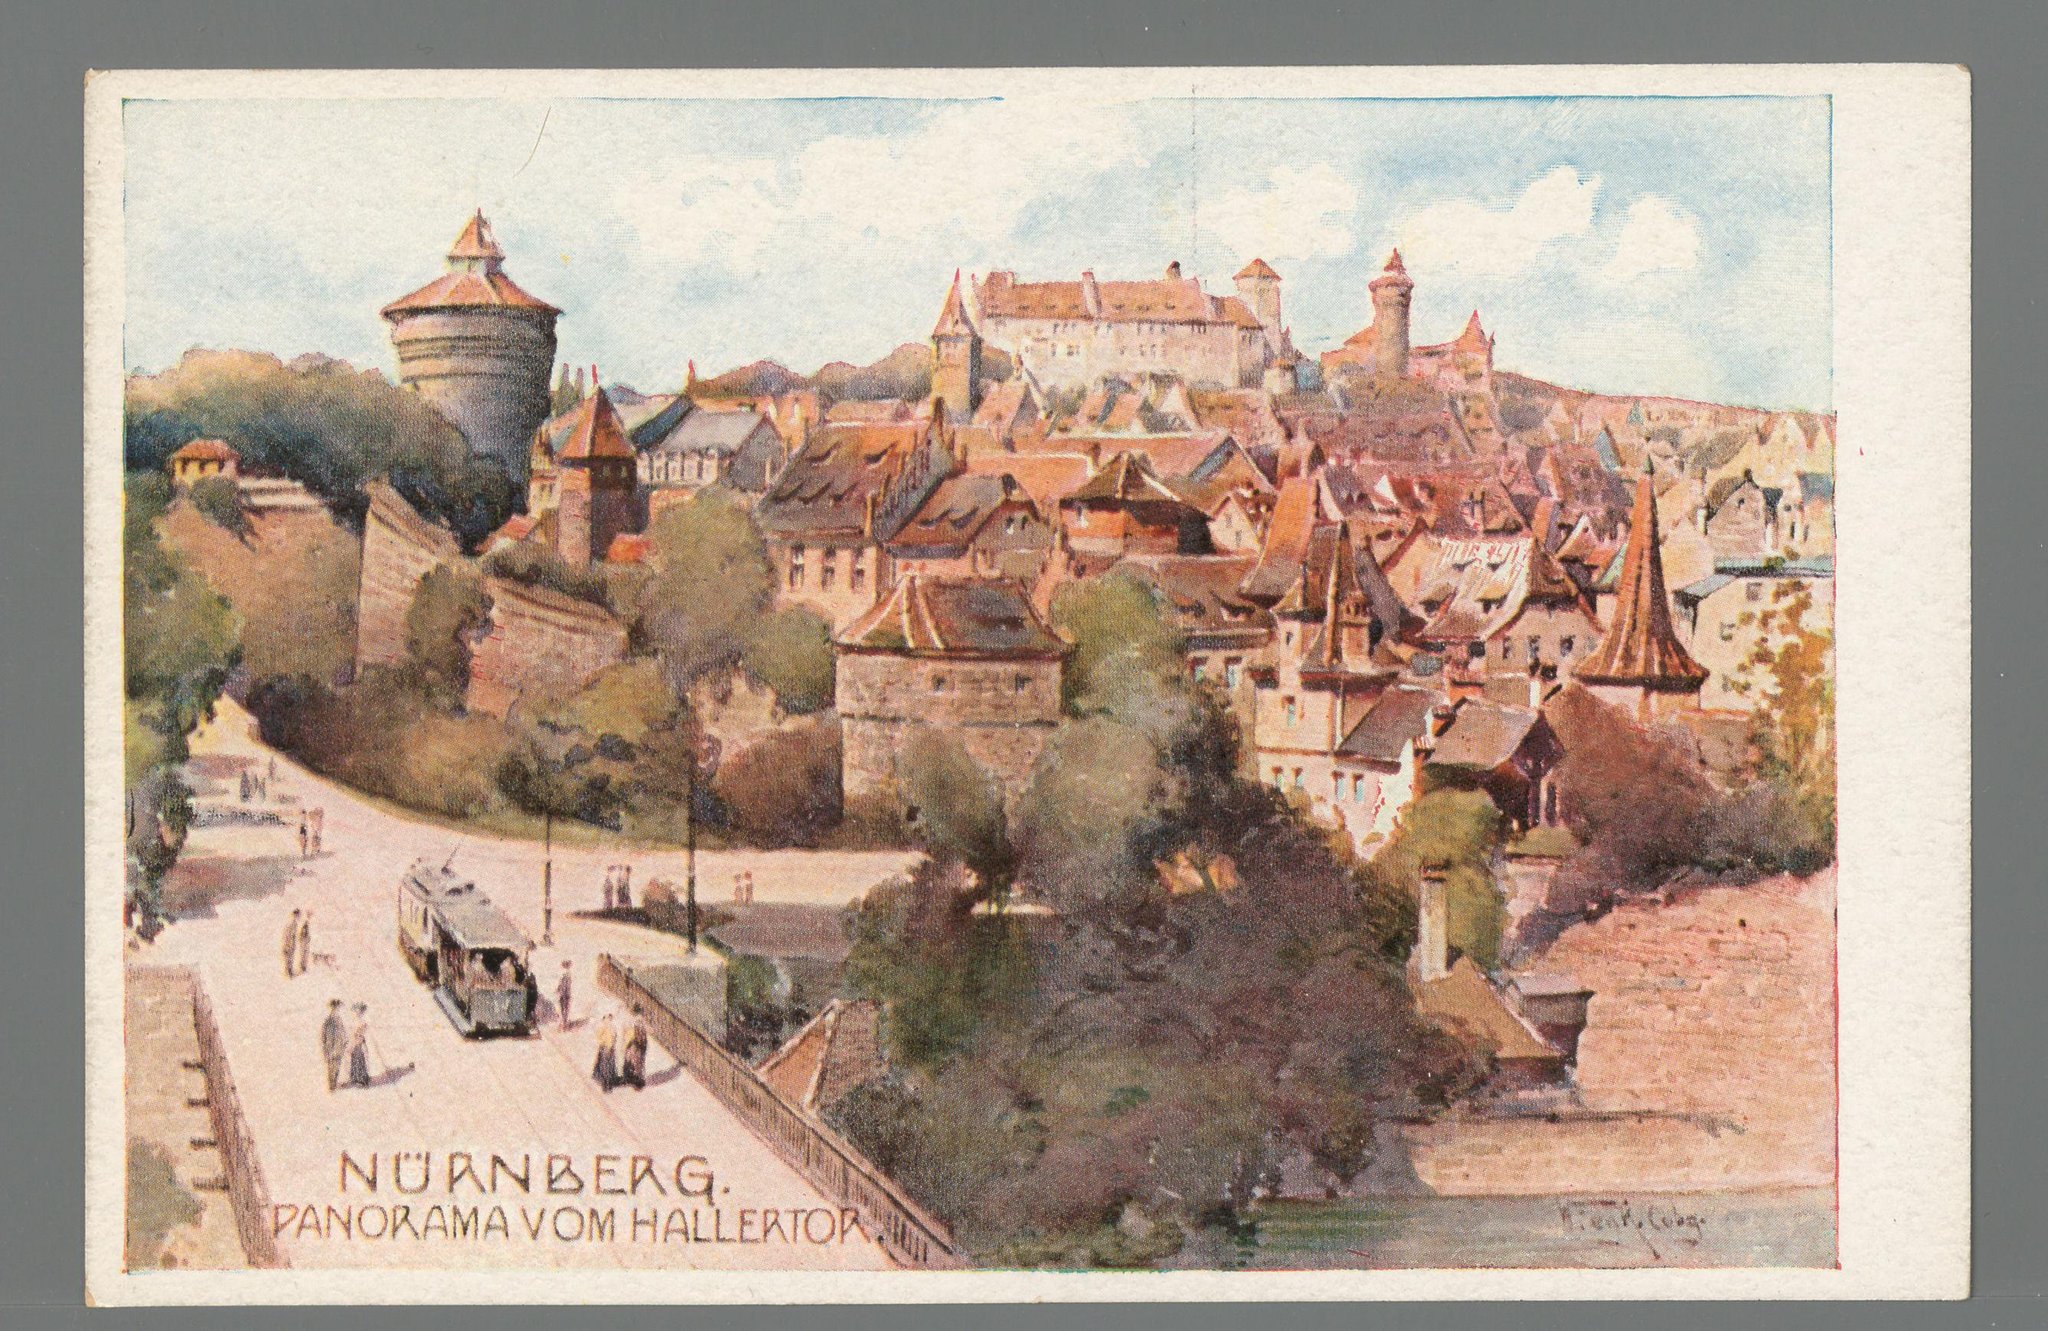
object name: ansichtkaart, prentbriefkaart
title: Nürnberg. Panorama vom Hallertor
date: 1905-1930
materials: cardboard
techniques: color autotype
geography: nuremberg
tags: prospect of city, town panorama, silhouette of city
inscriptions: inscription: ‘J Wien K’